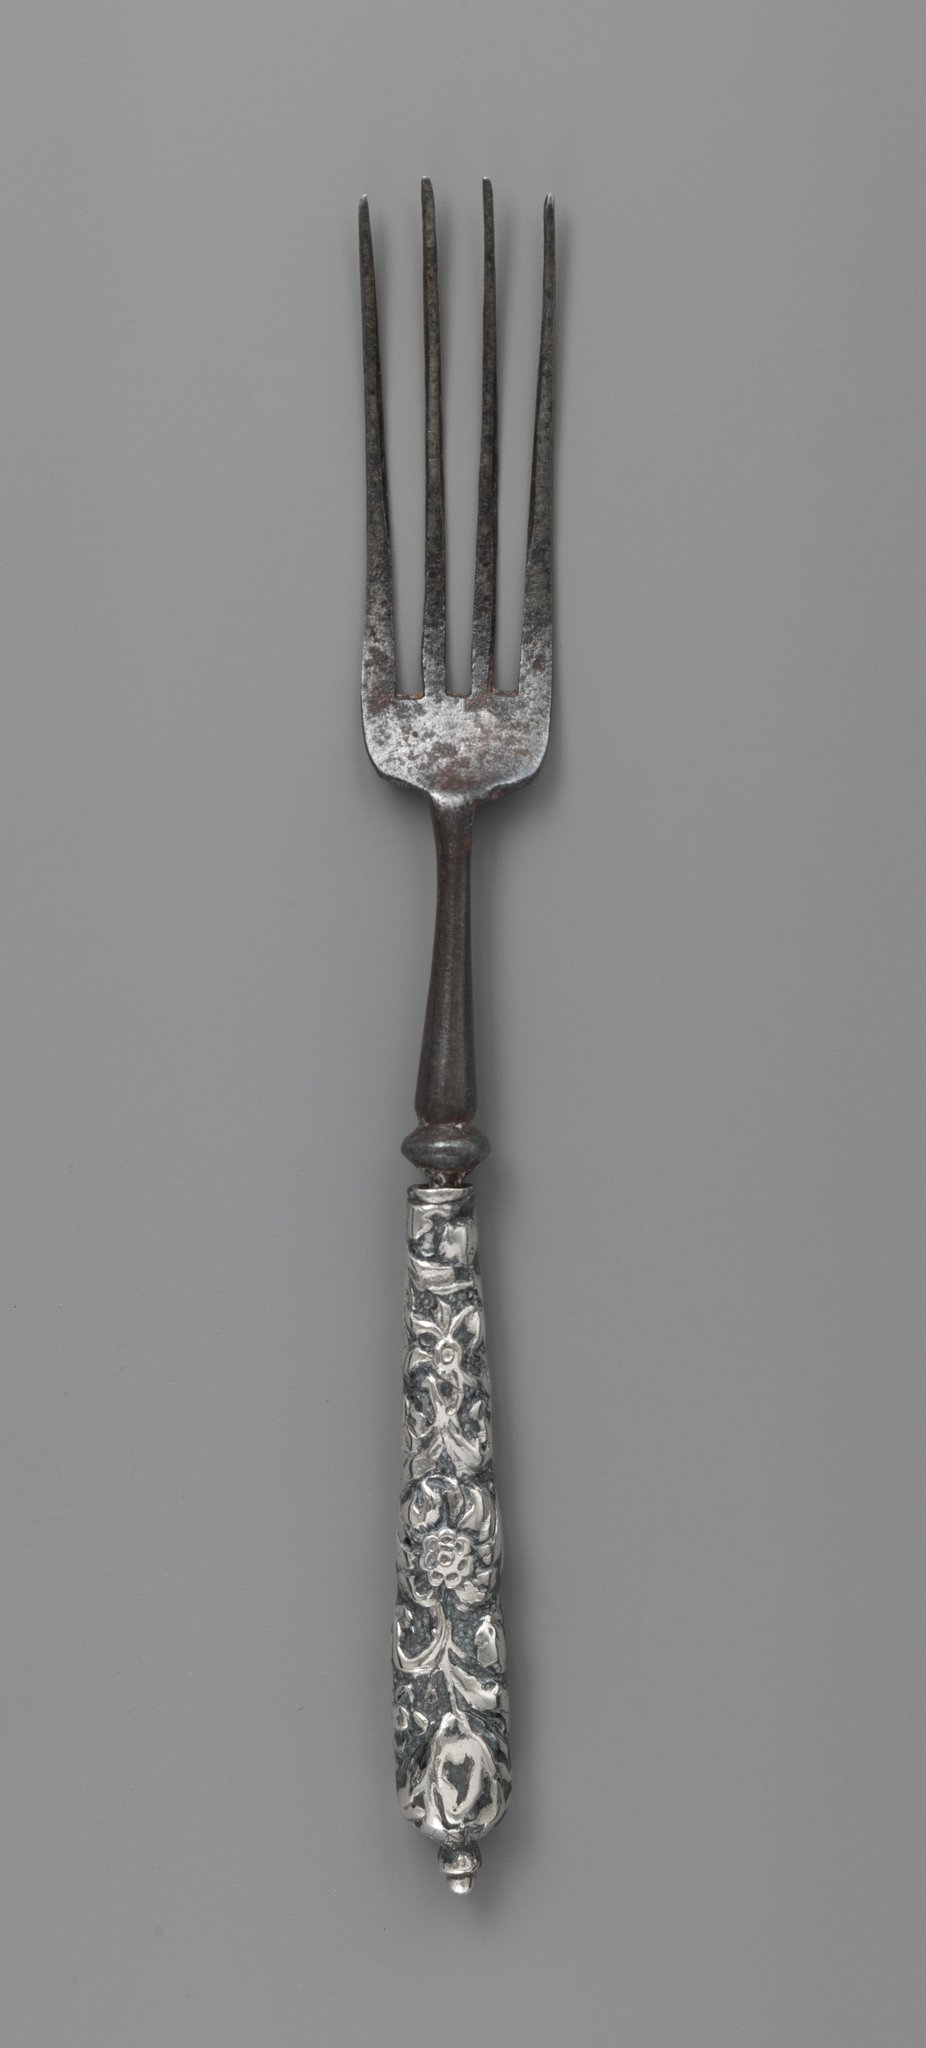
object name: fork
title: Fork (part of a set)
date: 1501-1700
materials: silver, steel